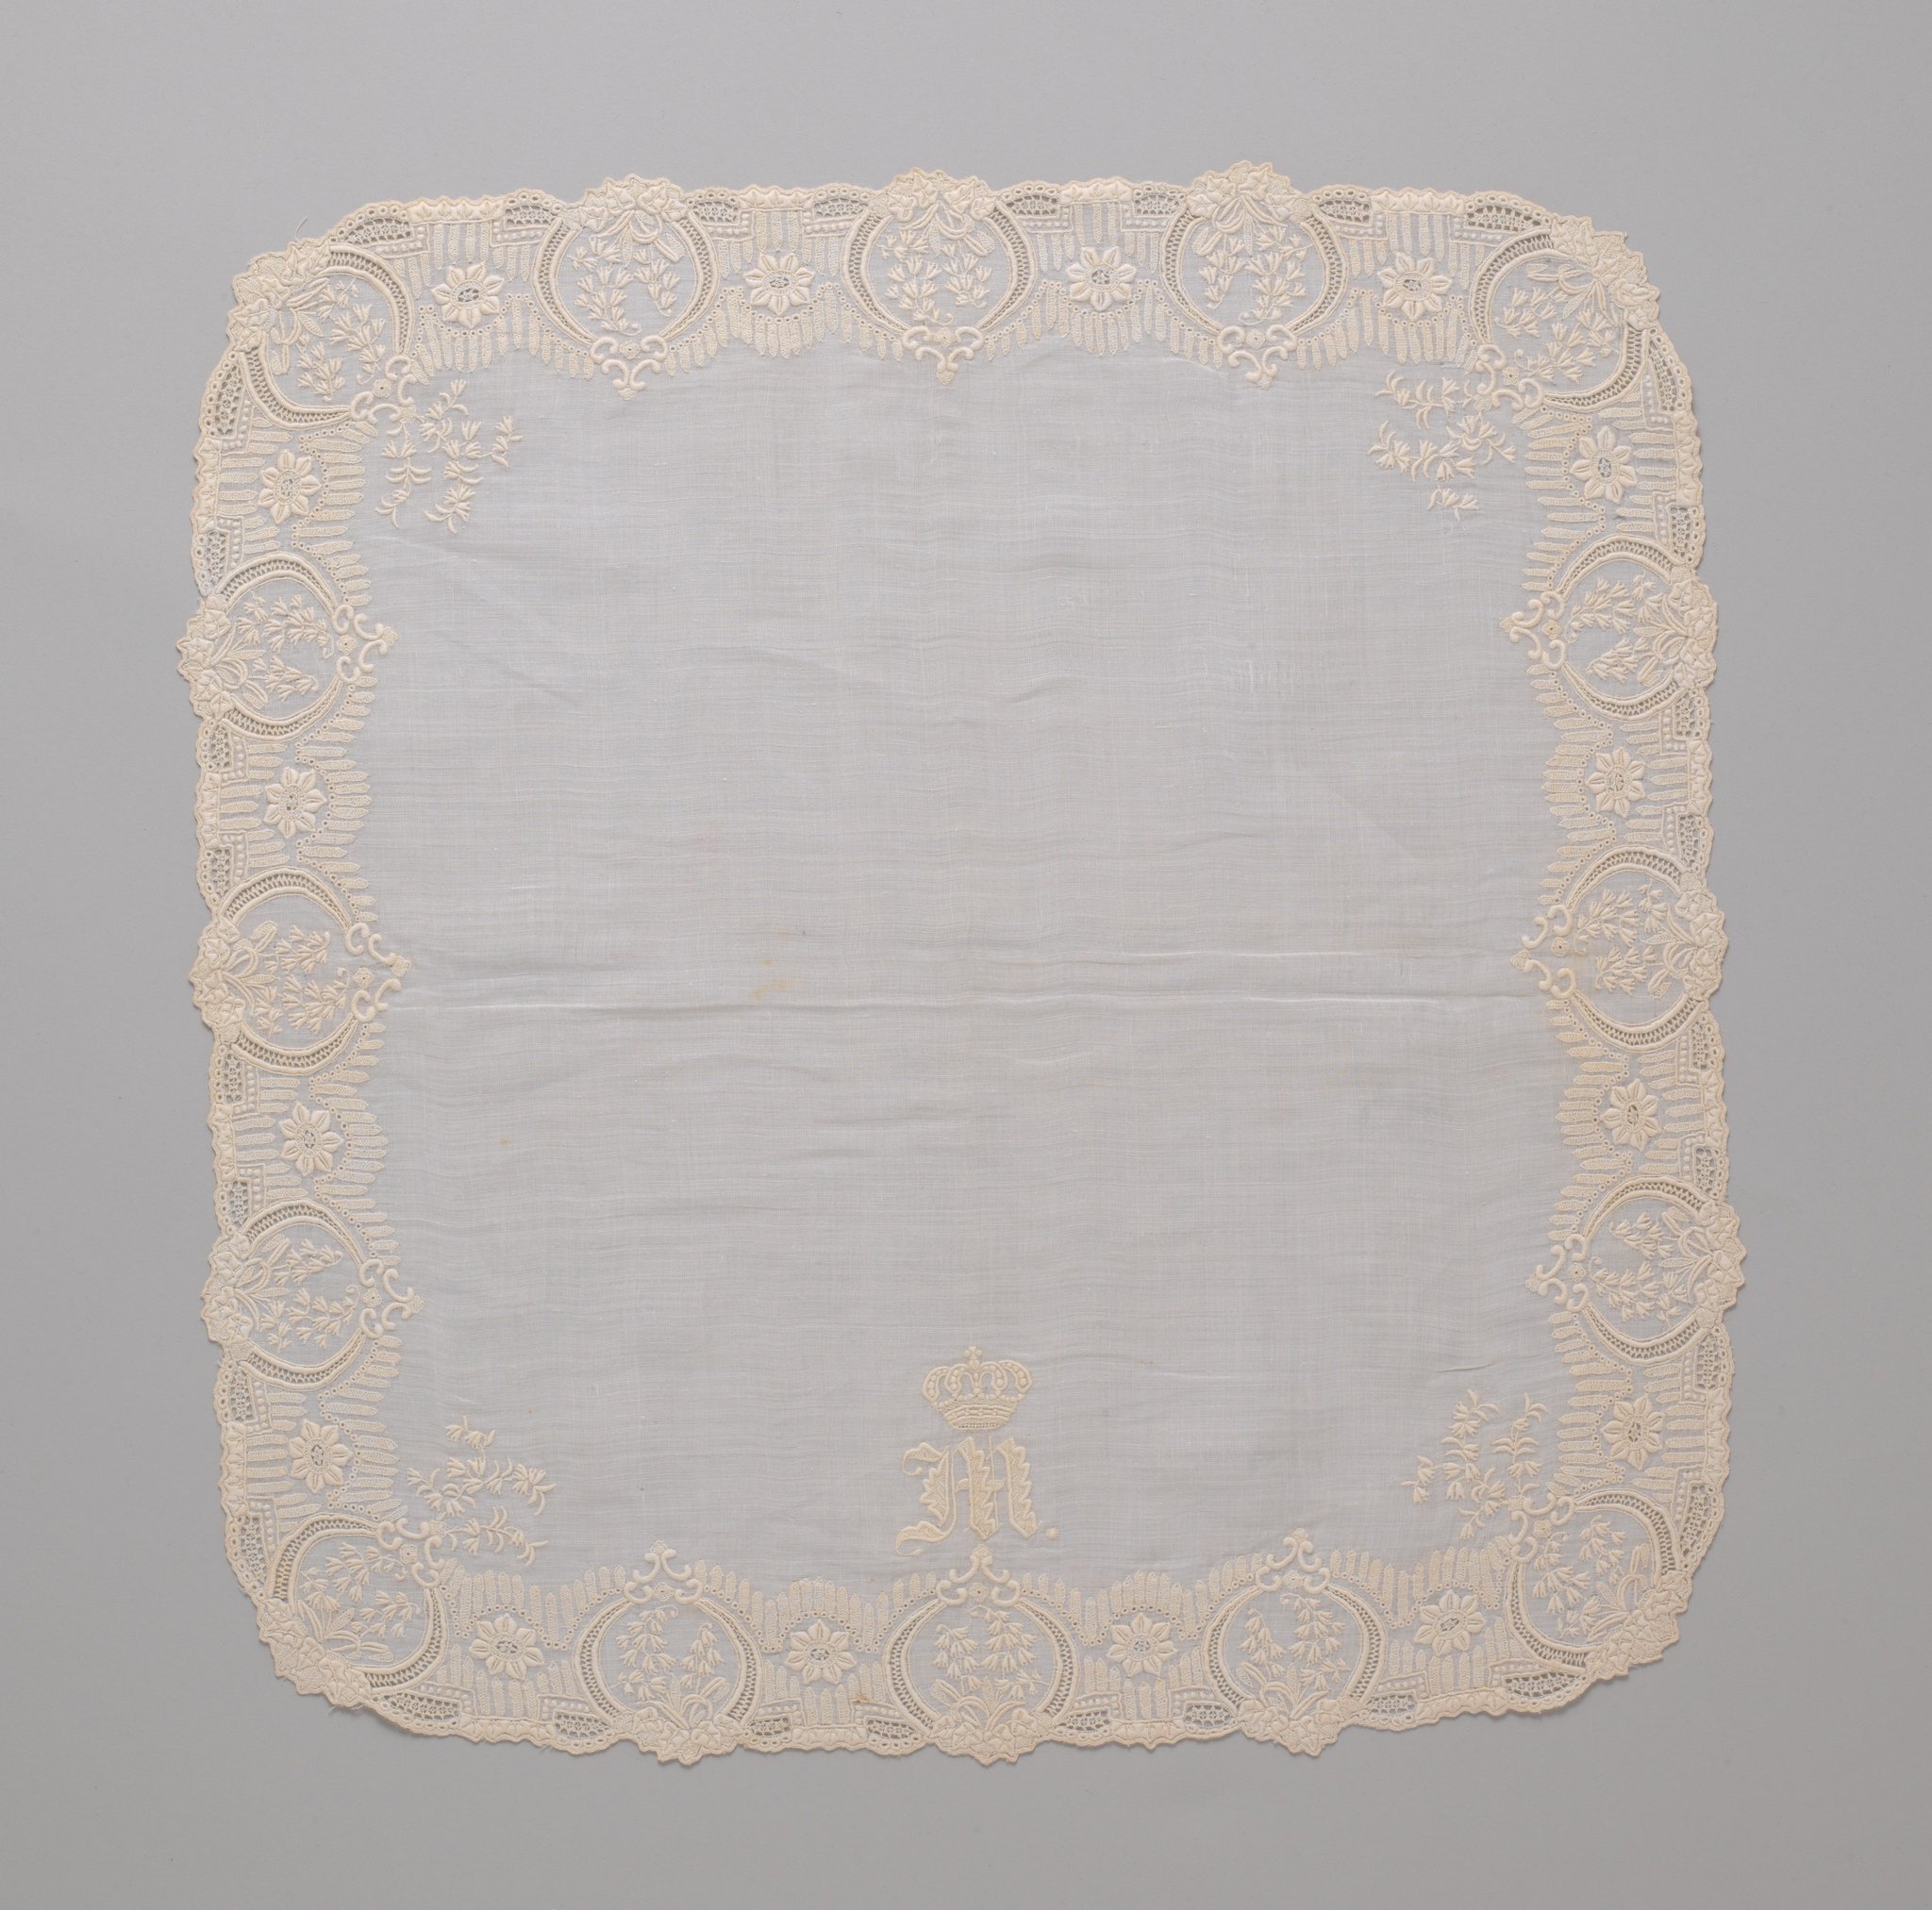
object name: handkerchief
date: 1840-1880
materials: linen, silk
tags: flowers